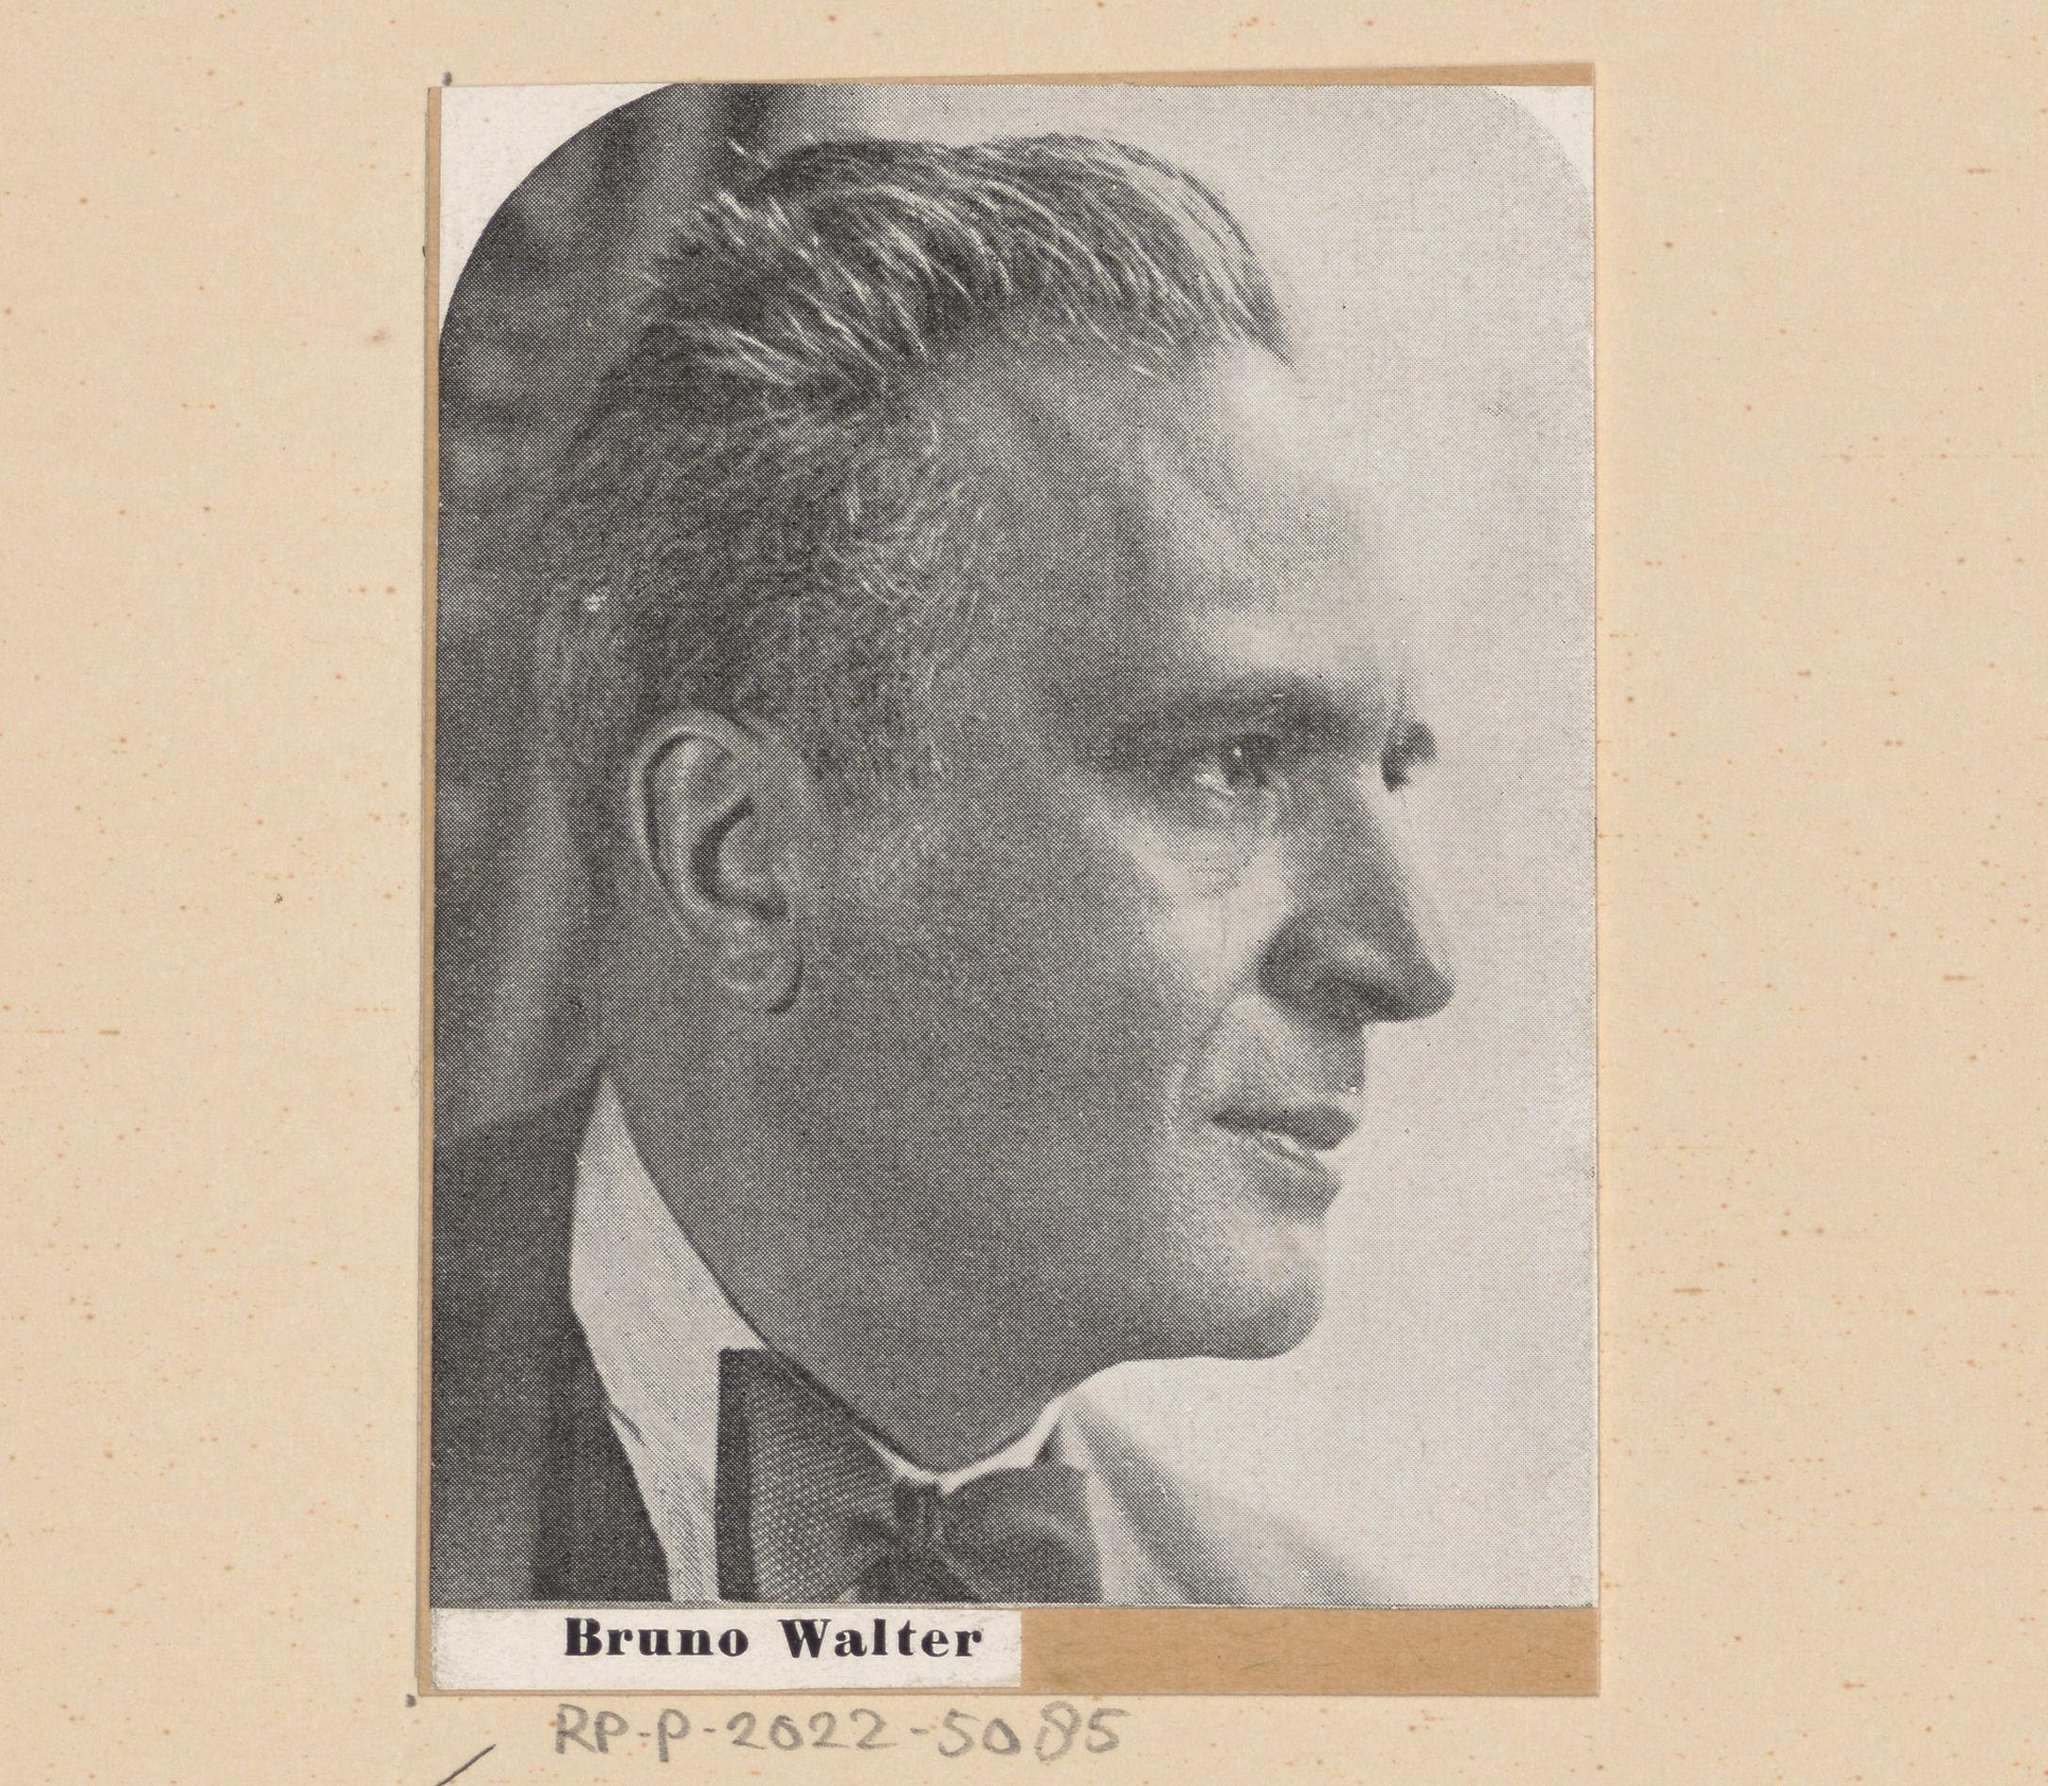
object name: photomechanical print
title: Portret van Bruno Walter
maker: Anonymous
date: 1937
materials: paper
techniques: autotype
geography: netherlands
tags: historical persons, conductor ~ music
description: Prent mogelijk uit: De kunst, nr. 1421, 25 september 1937.